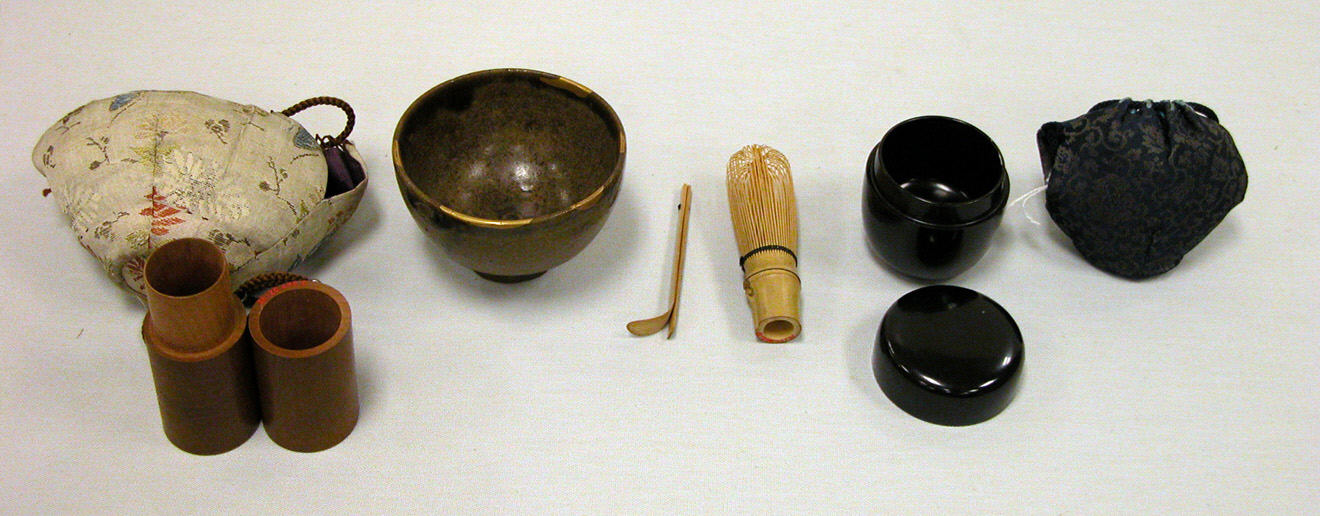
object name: teabowl and accessory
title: Teabowl and Accessories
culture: japanese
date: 1701-1800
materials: bamboo, clay, glaze, lacquer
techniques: brocade, overglaze